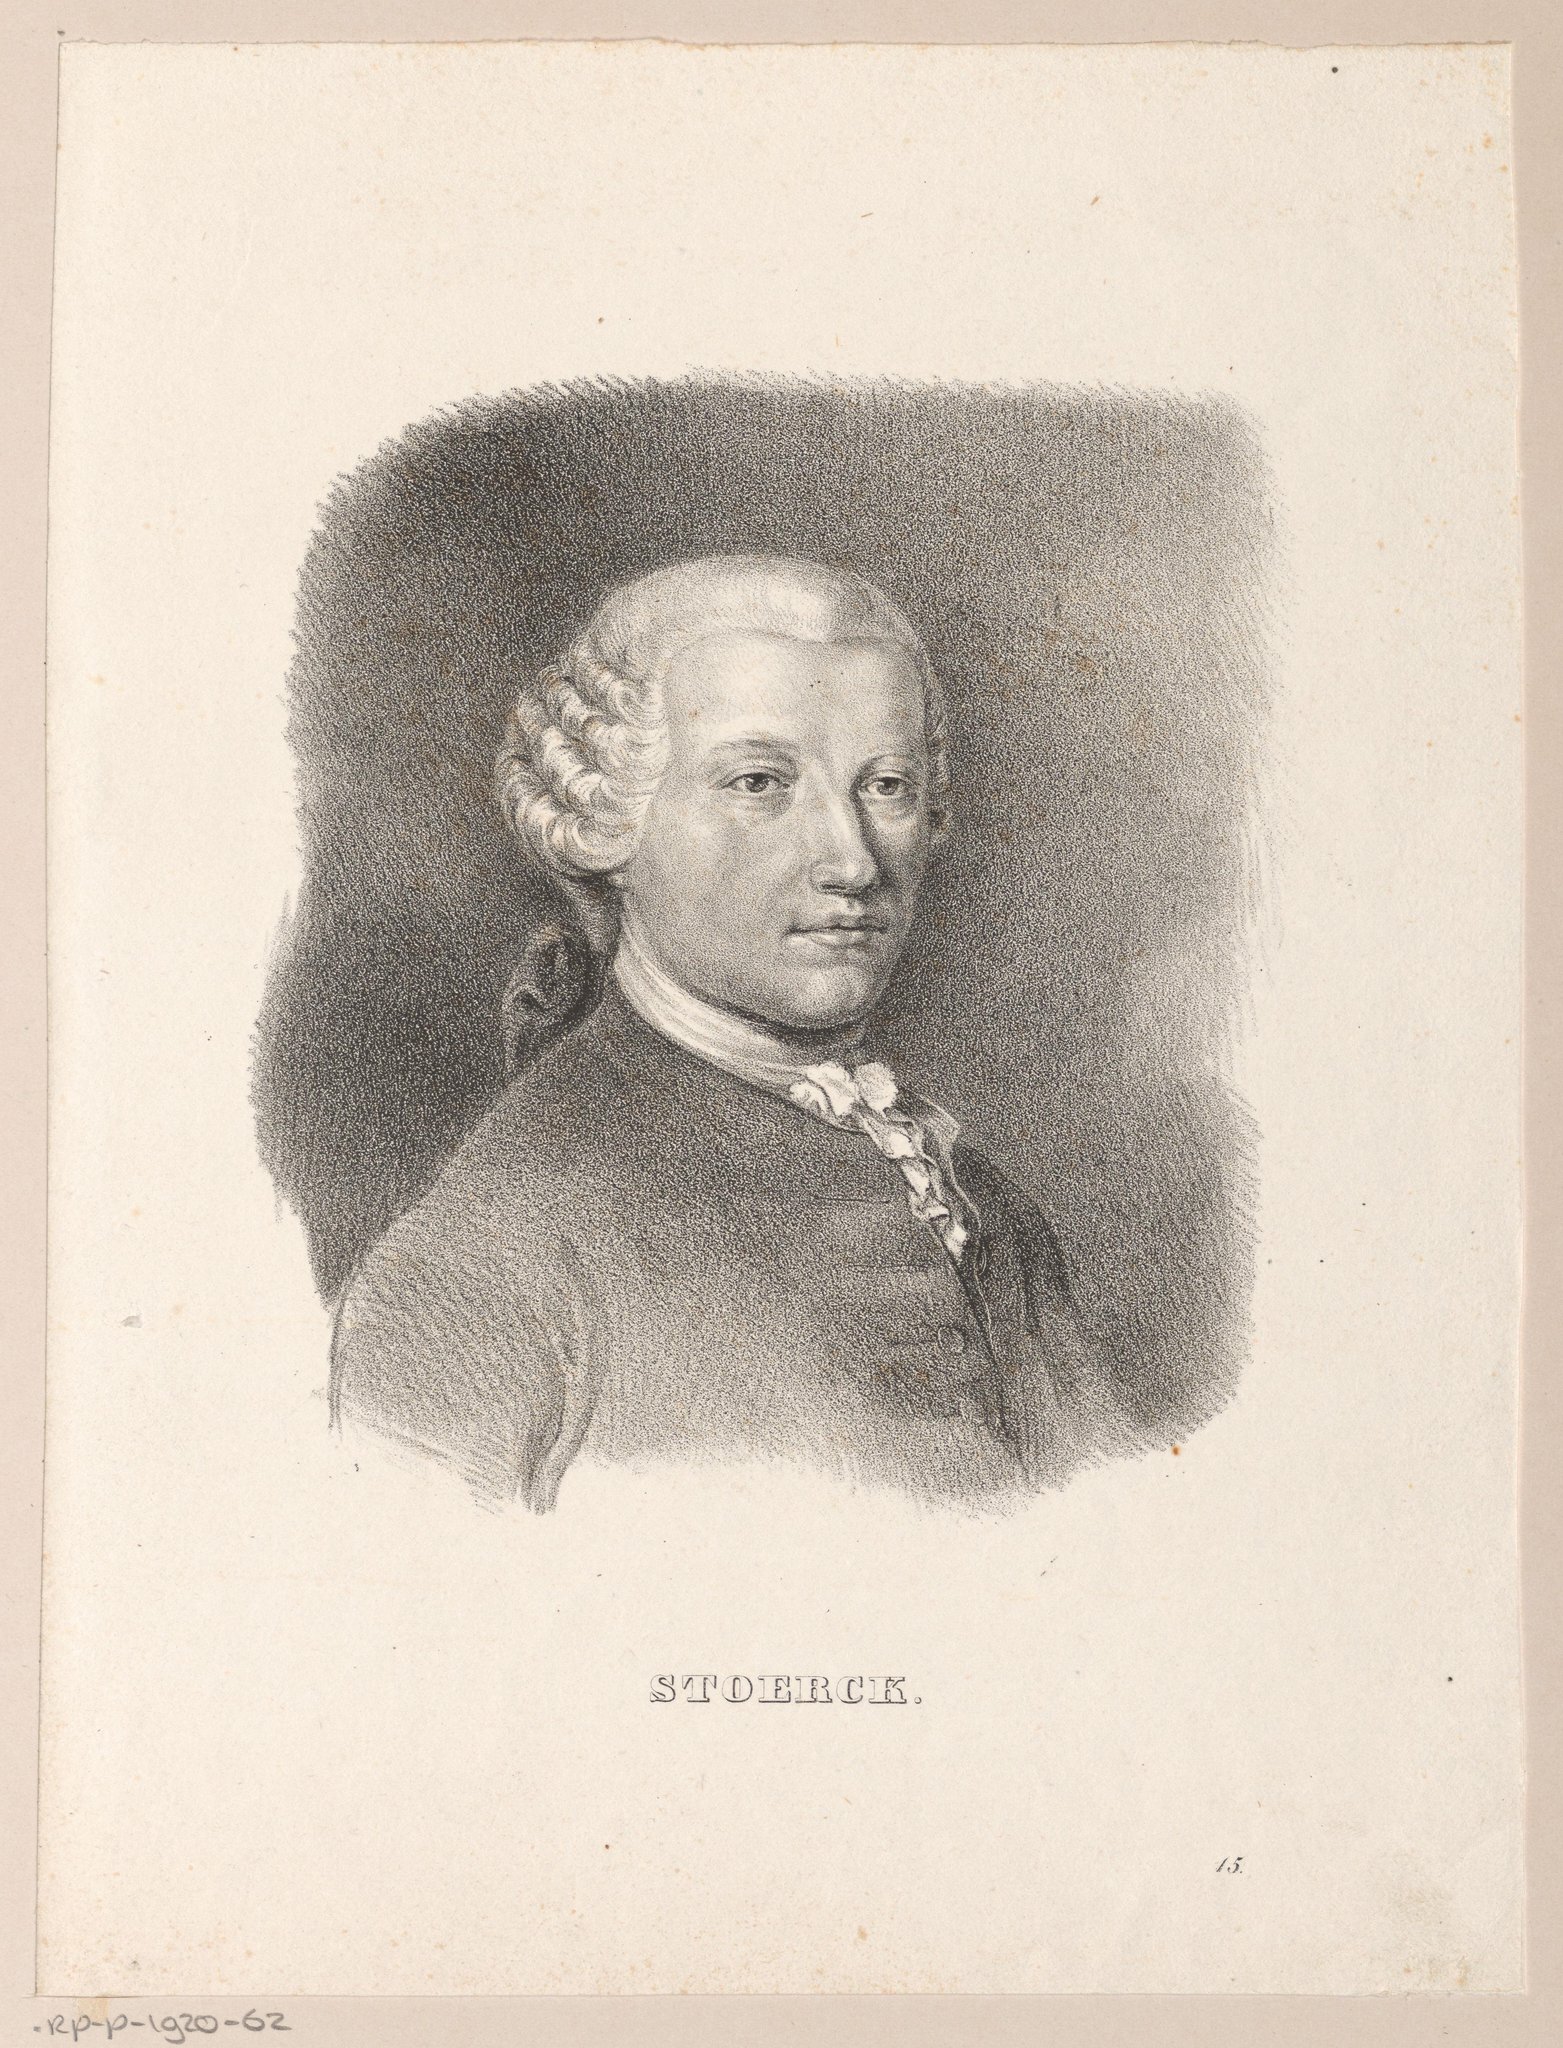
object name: print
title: Portret van Anton von Störck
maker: Anonymous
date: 1798-1850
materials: paper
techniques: lithograph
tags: historical persons, physician, doctor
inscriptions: collector's mark: Lugt 2228